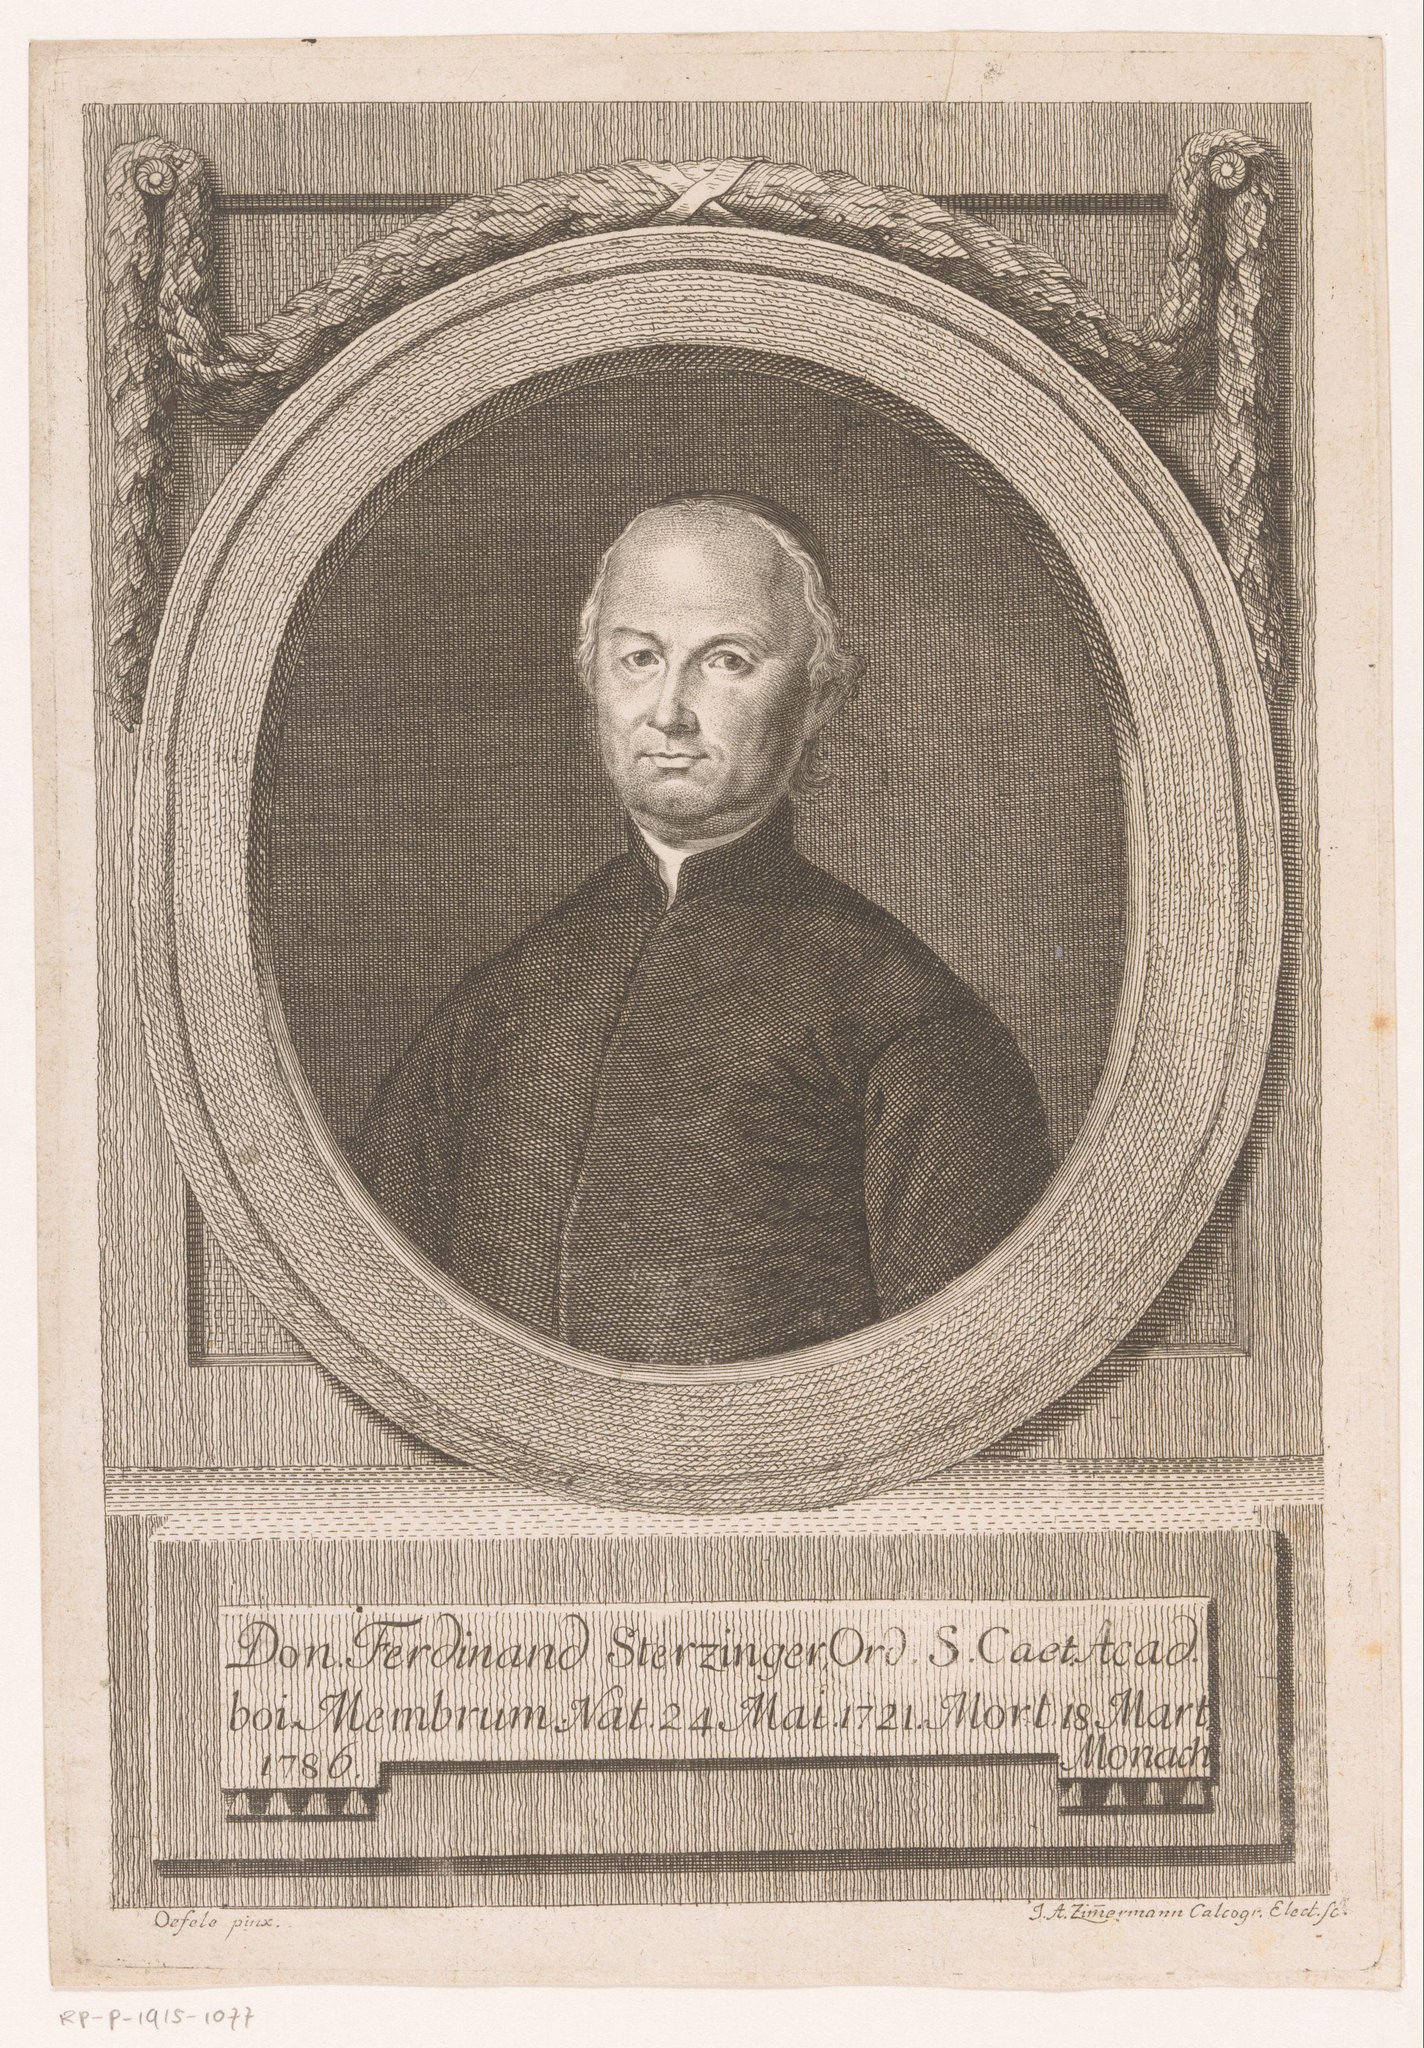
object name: print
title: Portret van Ferdinand Sterzinger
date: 1786-1797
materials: paper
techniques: engraving, etching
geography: germany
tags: historical persons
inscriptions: collector's mark: Lugt 2228